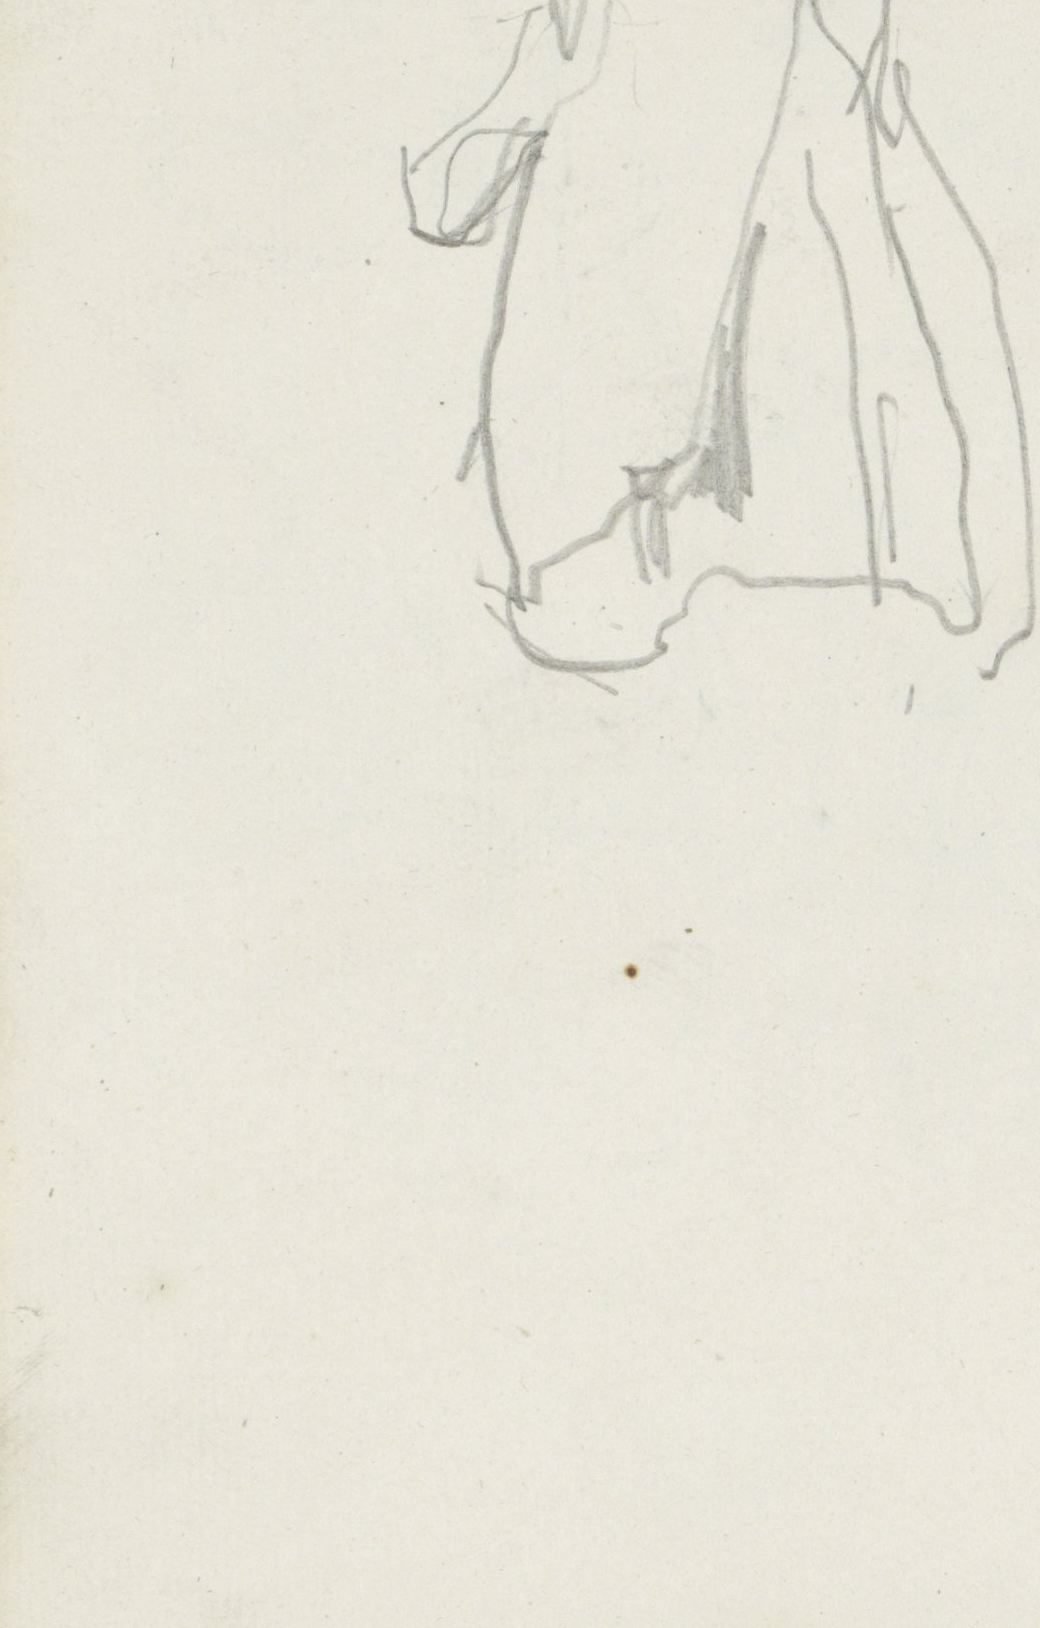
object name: sketchbook leaf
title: Studie, mogelijk van een kind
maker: george hendrik breitner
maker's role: draughtsman, painter, print maker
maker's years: 1857-1923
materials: paper, pencil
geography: the hague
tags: child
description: Pagina 49 uit een schetsboek met 28 bladen.